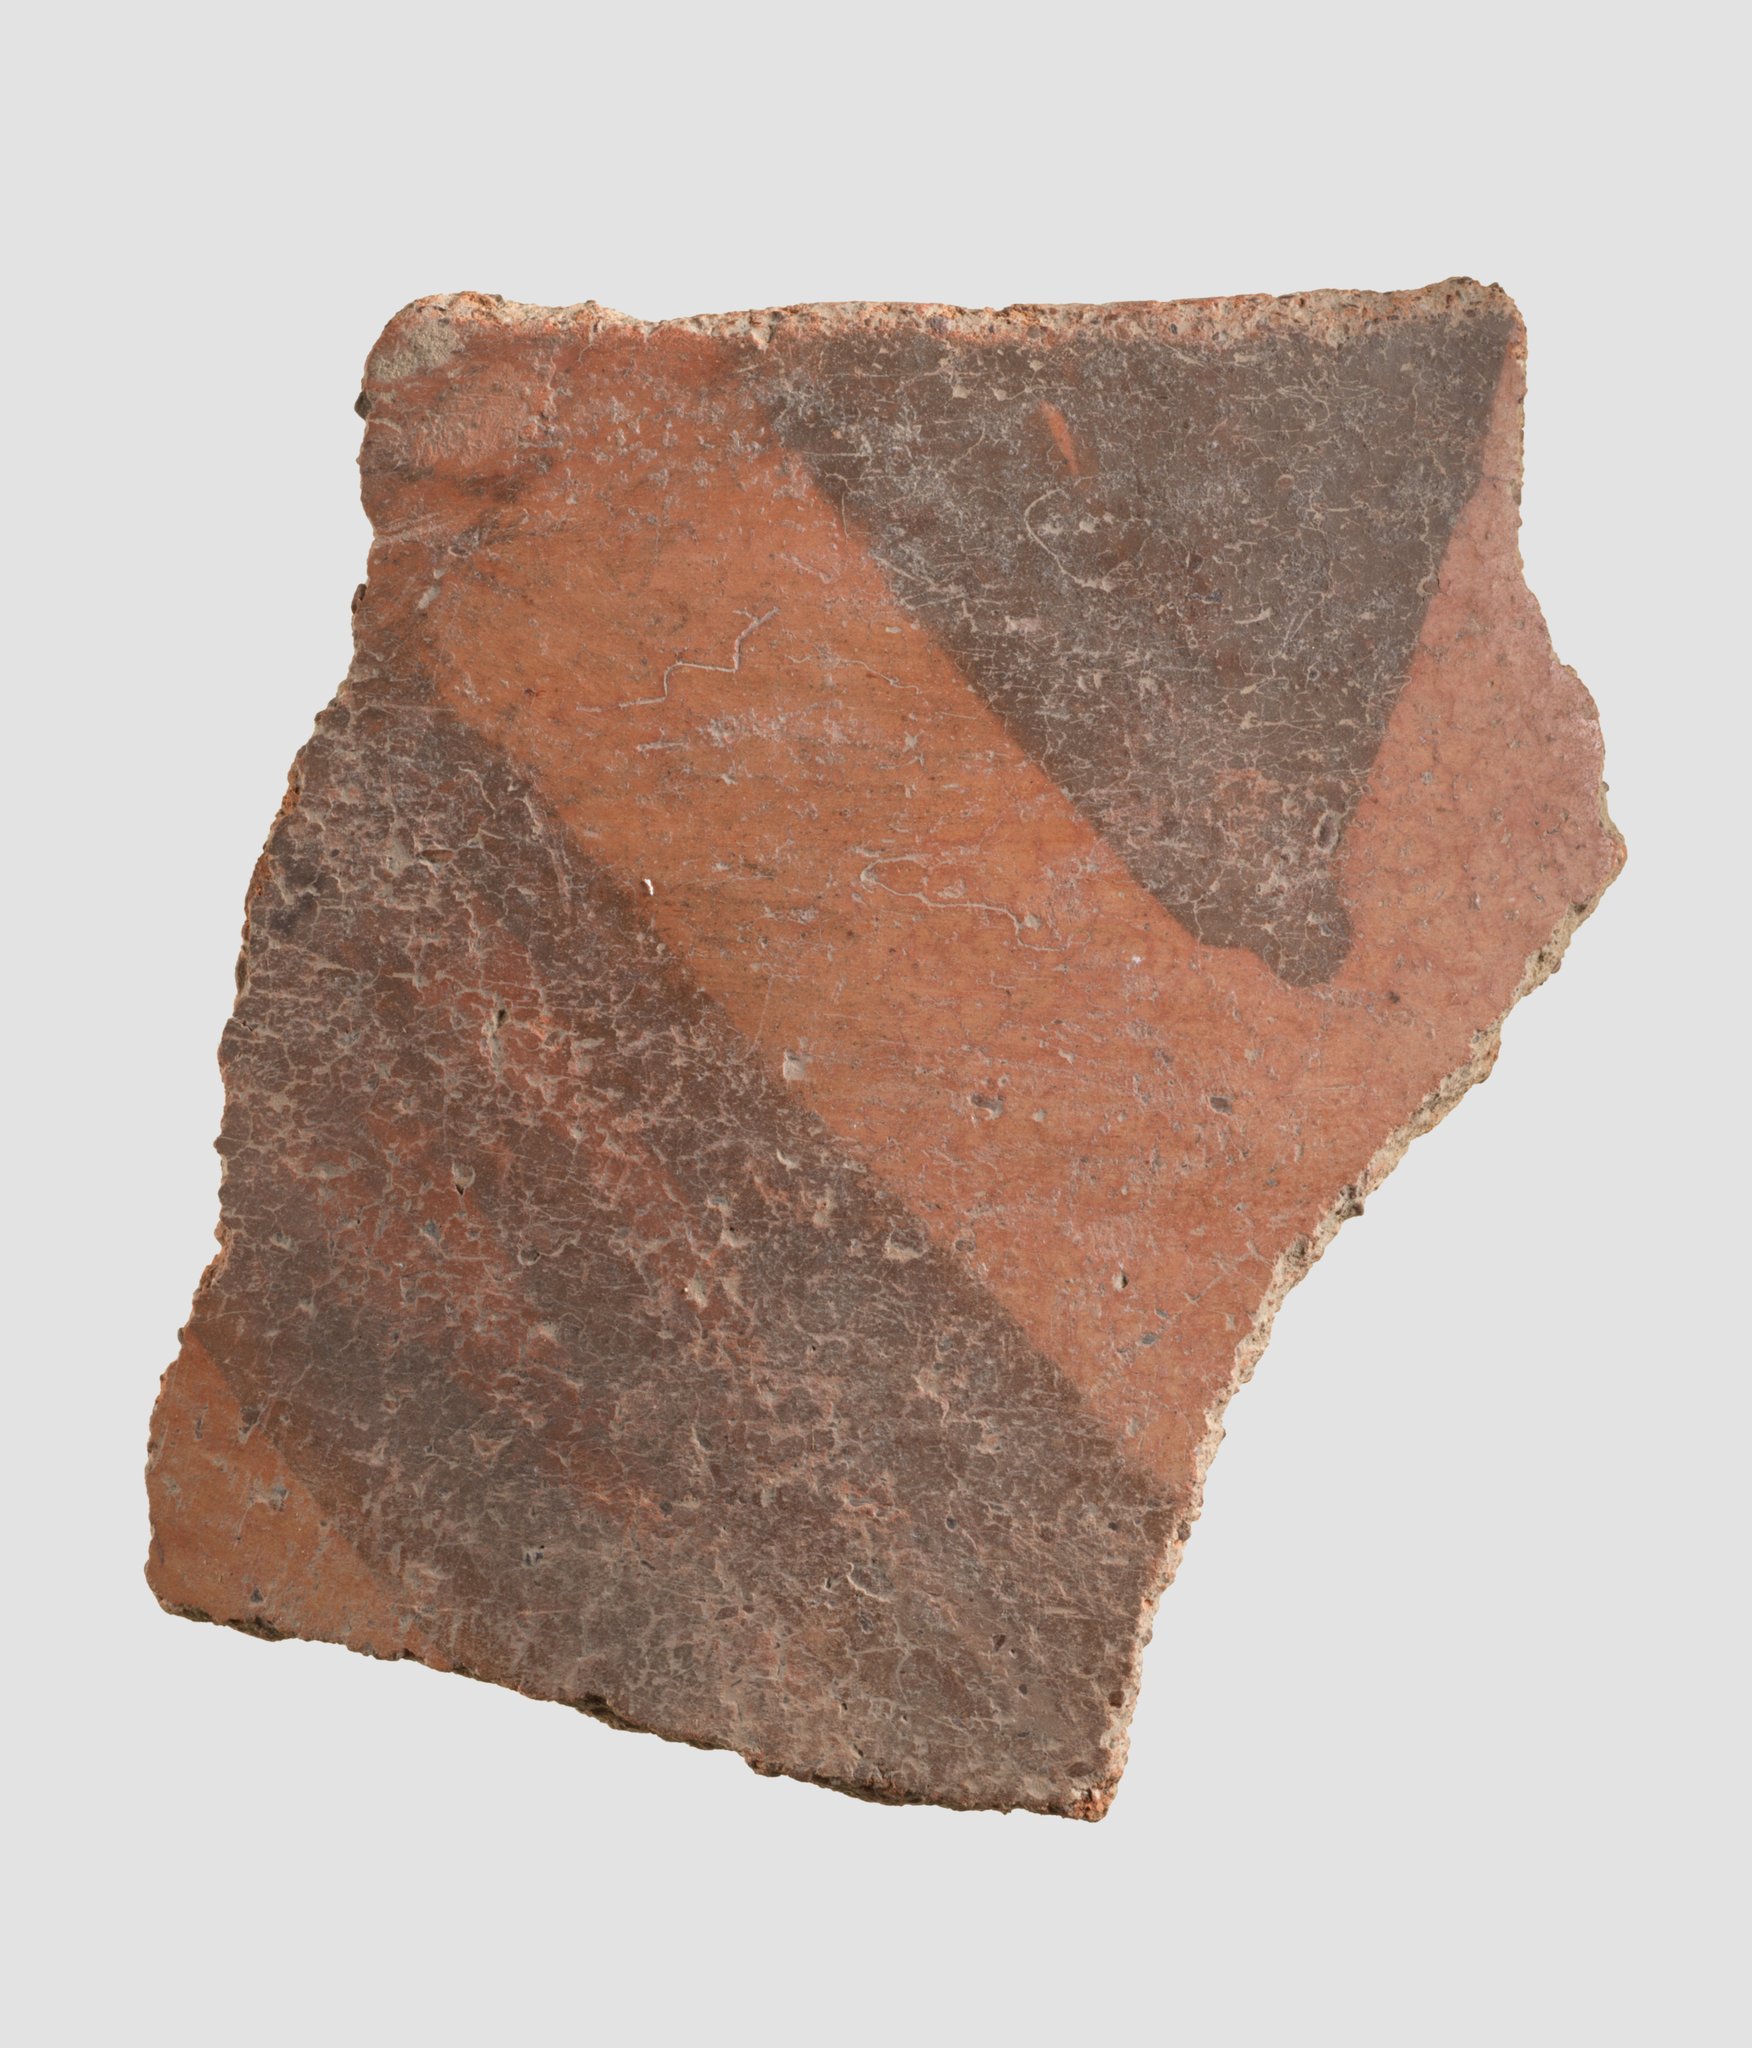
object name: sherd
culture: iranian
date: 3100-2700 BCE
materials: ceramic, paint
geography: iran